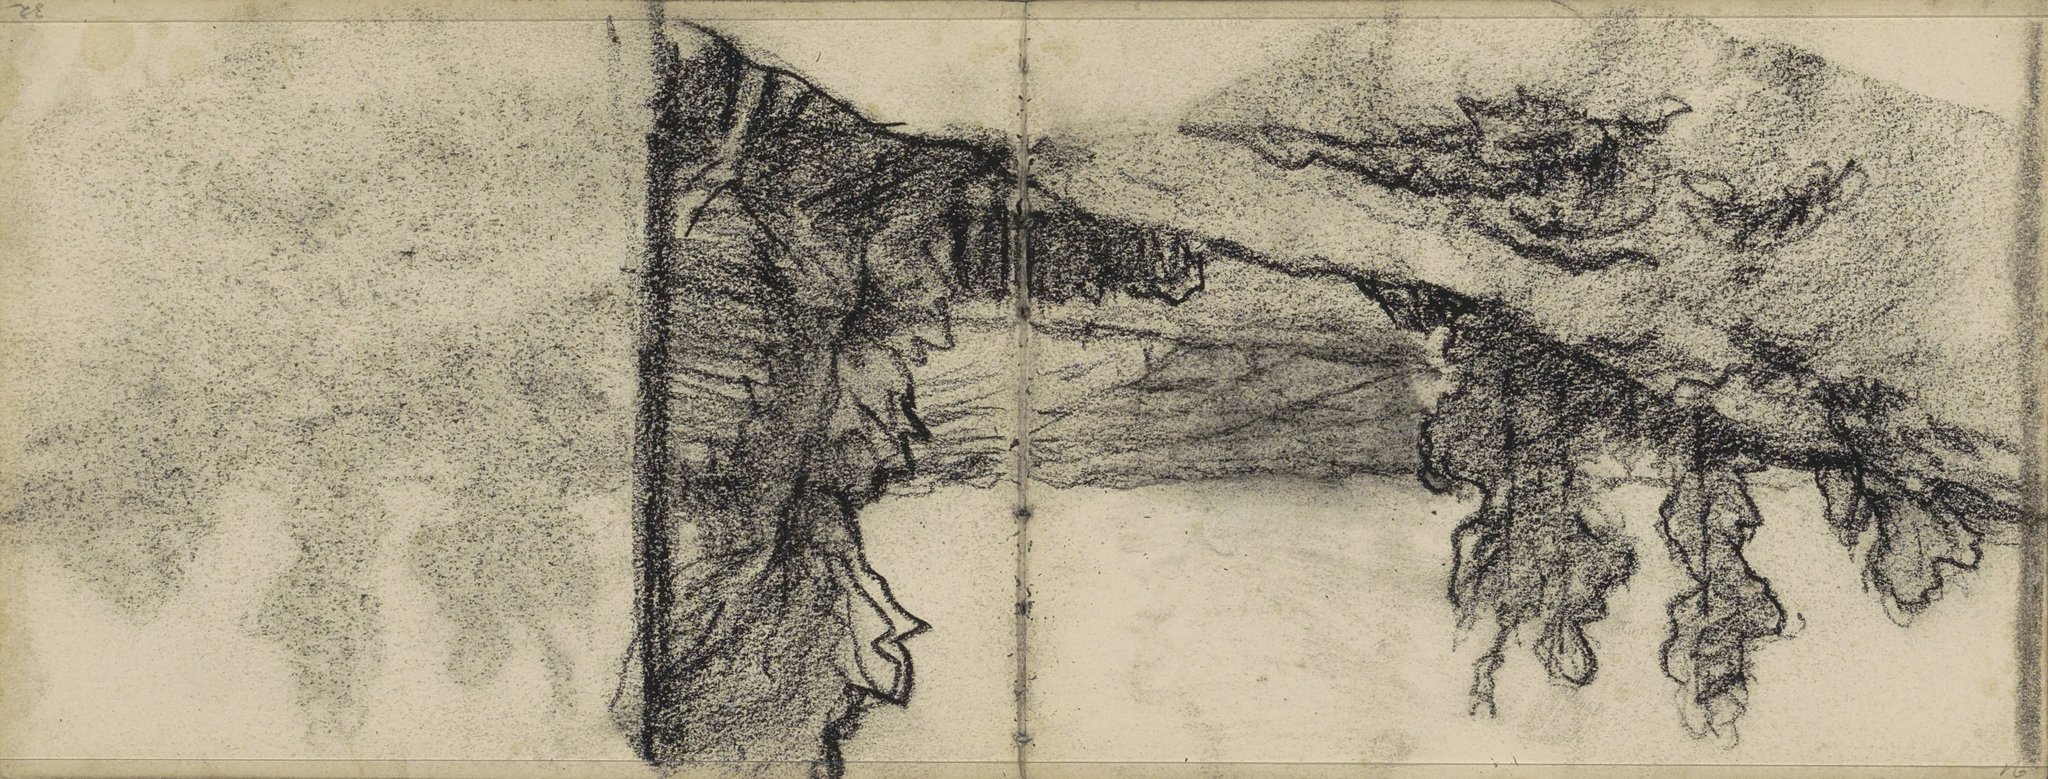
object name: sketchbook leaf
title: Heuvellandschap met bomen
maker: hermannus adrianus van oosterzee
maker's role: draughtsman, painter, print maker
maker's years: 1863-1933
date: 1893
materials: charcoal, paper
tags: low hill country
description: Blad 15 verso 16 recto uit een schetsboek met 23 bladen.